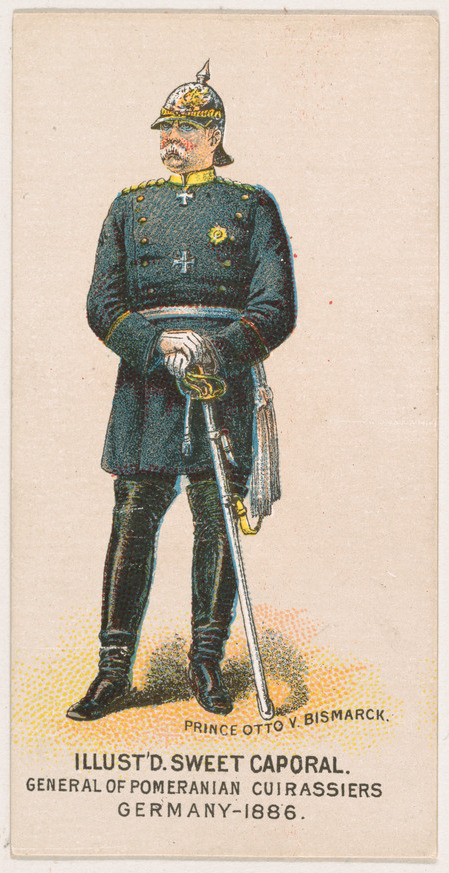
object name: print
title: General, Pomeranian Cuirassiers, Germany, 1886, from the Military Series (N224) issued by Kinney Tobacco Company to promote Sweet Caporal Cigarettes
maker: kinney brothers tobacco company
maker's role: publisher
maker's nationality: american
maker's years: 1869-2011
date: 1888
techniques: color lithograph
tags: military,swords,men,generals